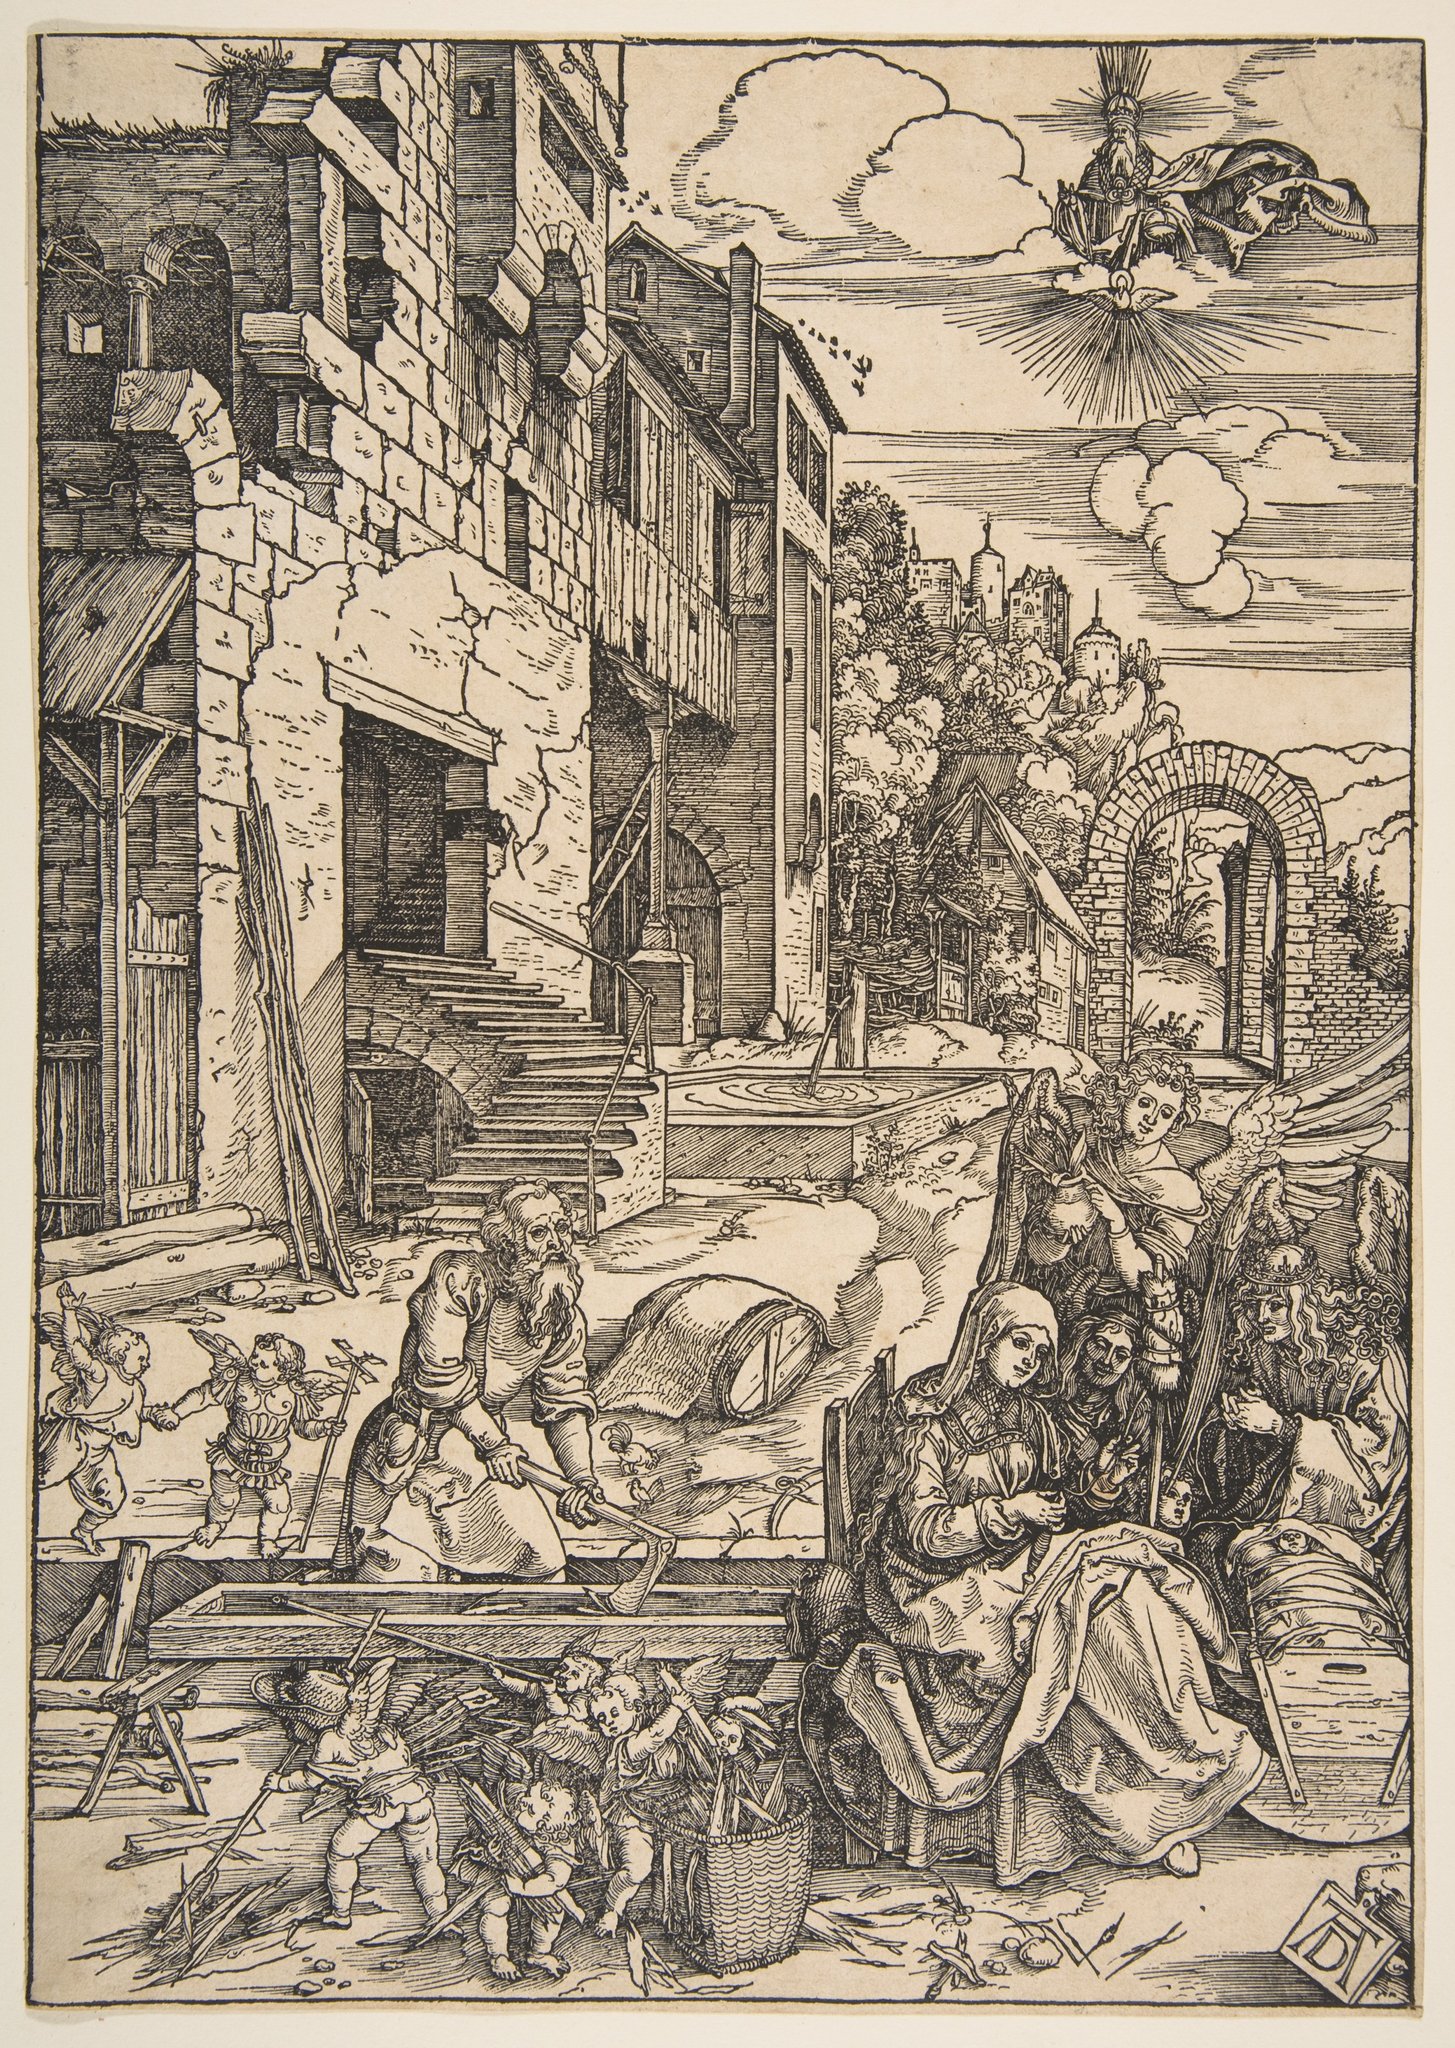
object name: print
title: The Sojourn of the Holy Family in Egypt, from "The Life of the Virgin"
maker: albrecht dürer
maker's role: artist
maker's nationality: german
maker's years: 1471-1528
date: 1511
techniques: woodcut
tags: men,angels,holy family,working